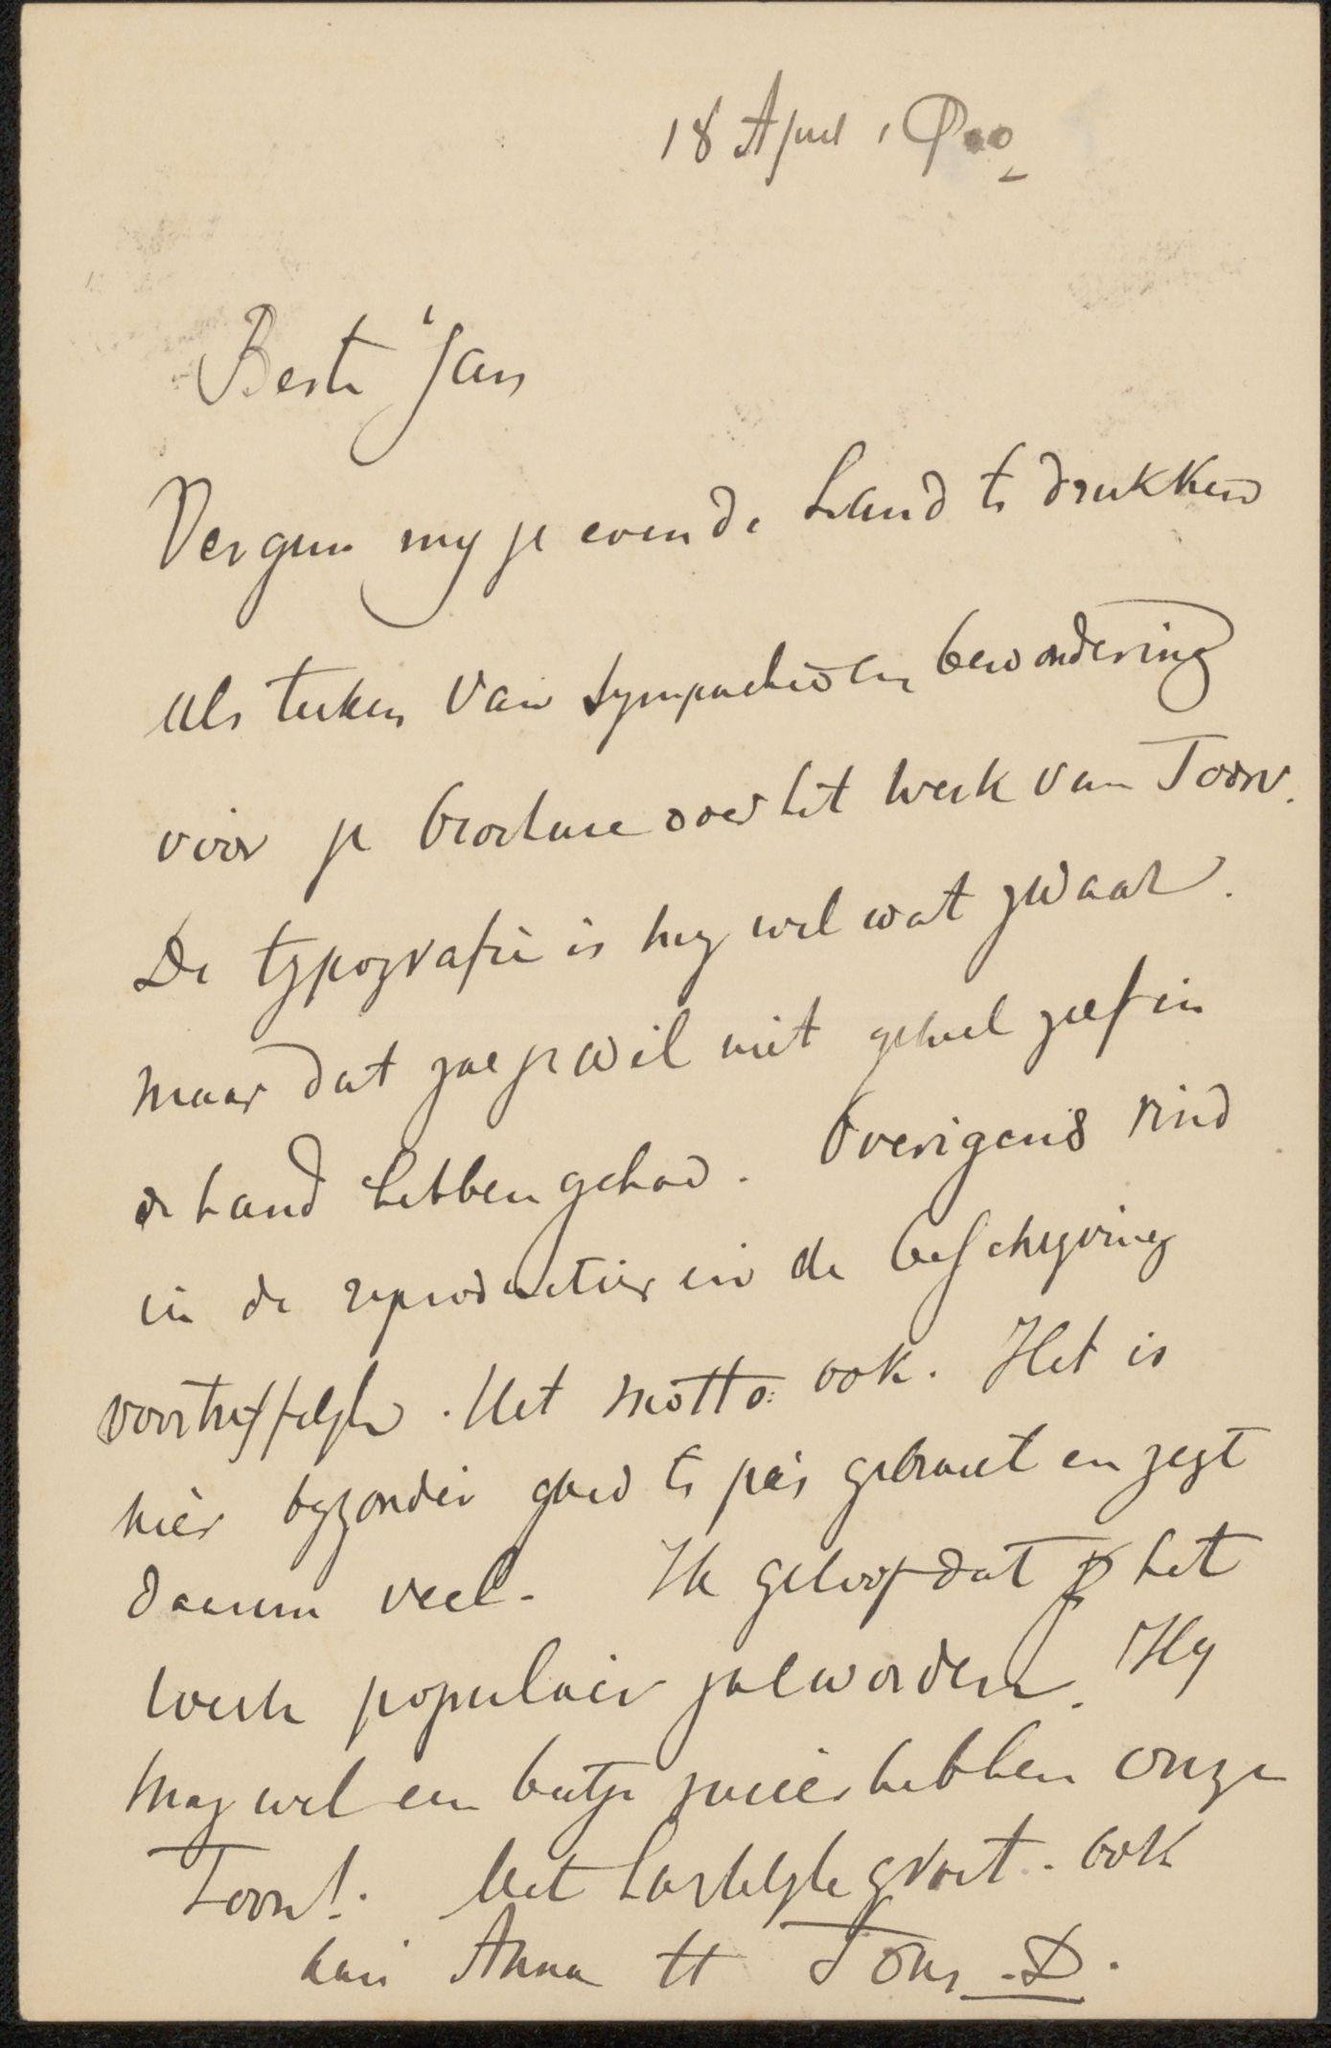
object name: letter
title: Brief aan Jan Veth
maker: alphons diepenbrock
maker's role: componist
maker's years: 1862-1921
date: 1900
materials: ink, paper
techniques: pen, writing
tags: jan veth, den bosch, amsterdam, painter, print maker, draughtsman, antoon derkinderen, printed matter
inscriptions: collector's mark: ‘RPK’